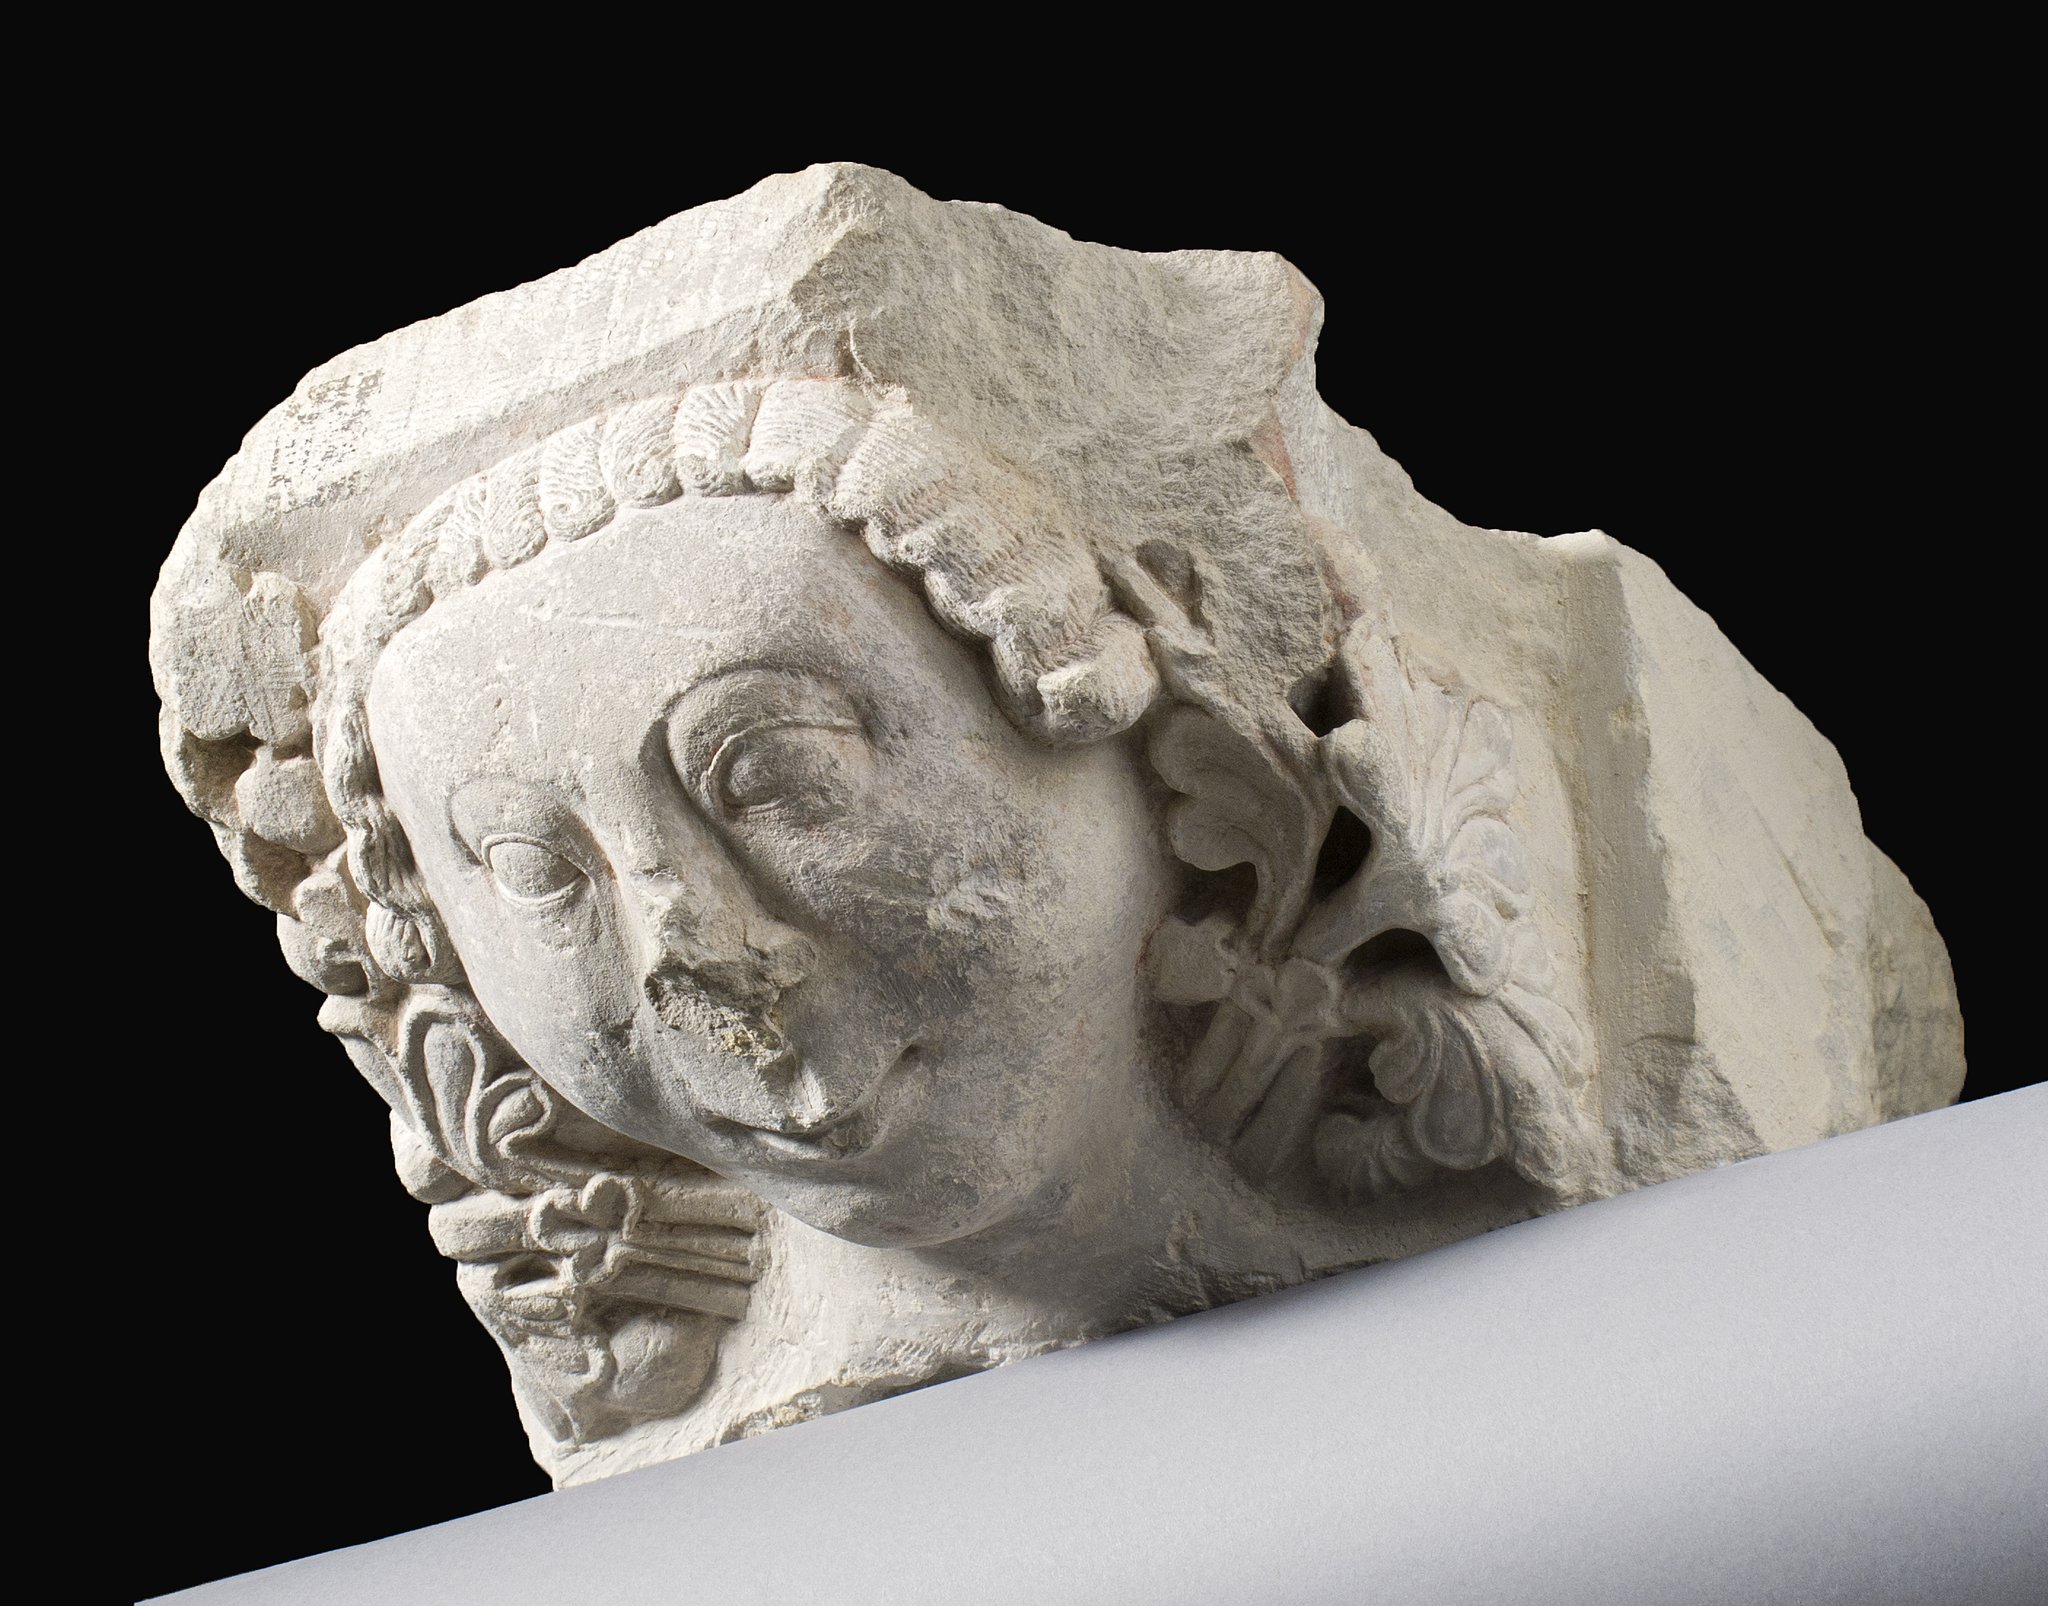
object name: corbel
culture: british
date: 1201-1300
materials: limestone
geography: england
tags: faces